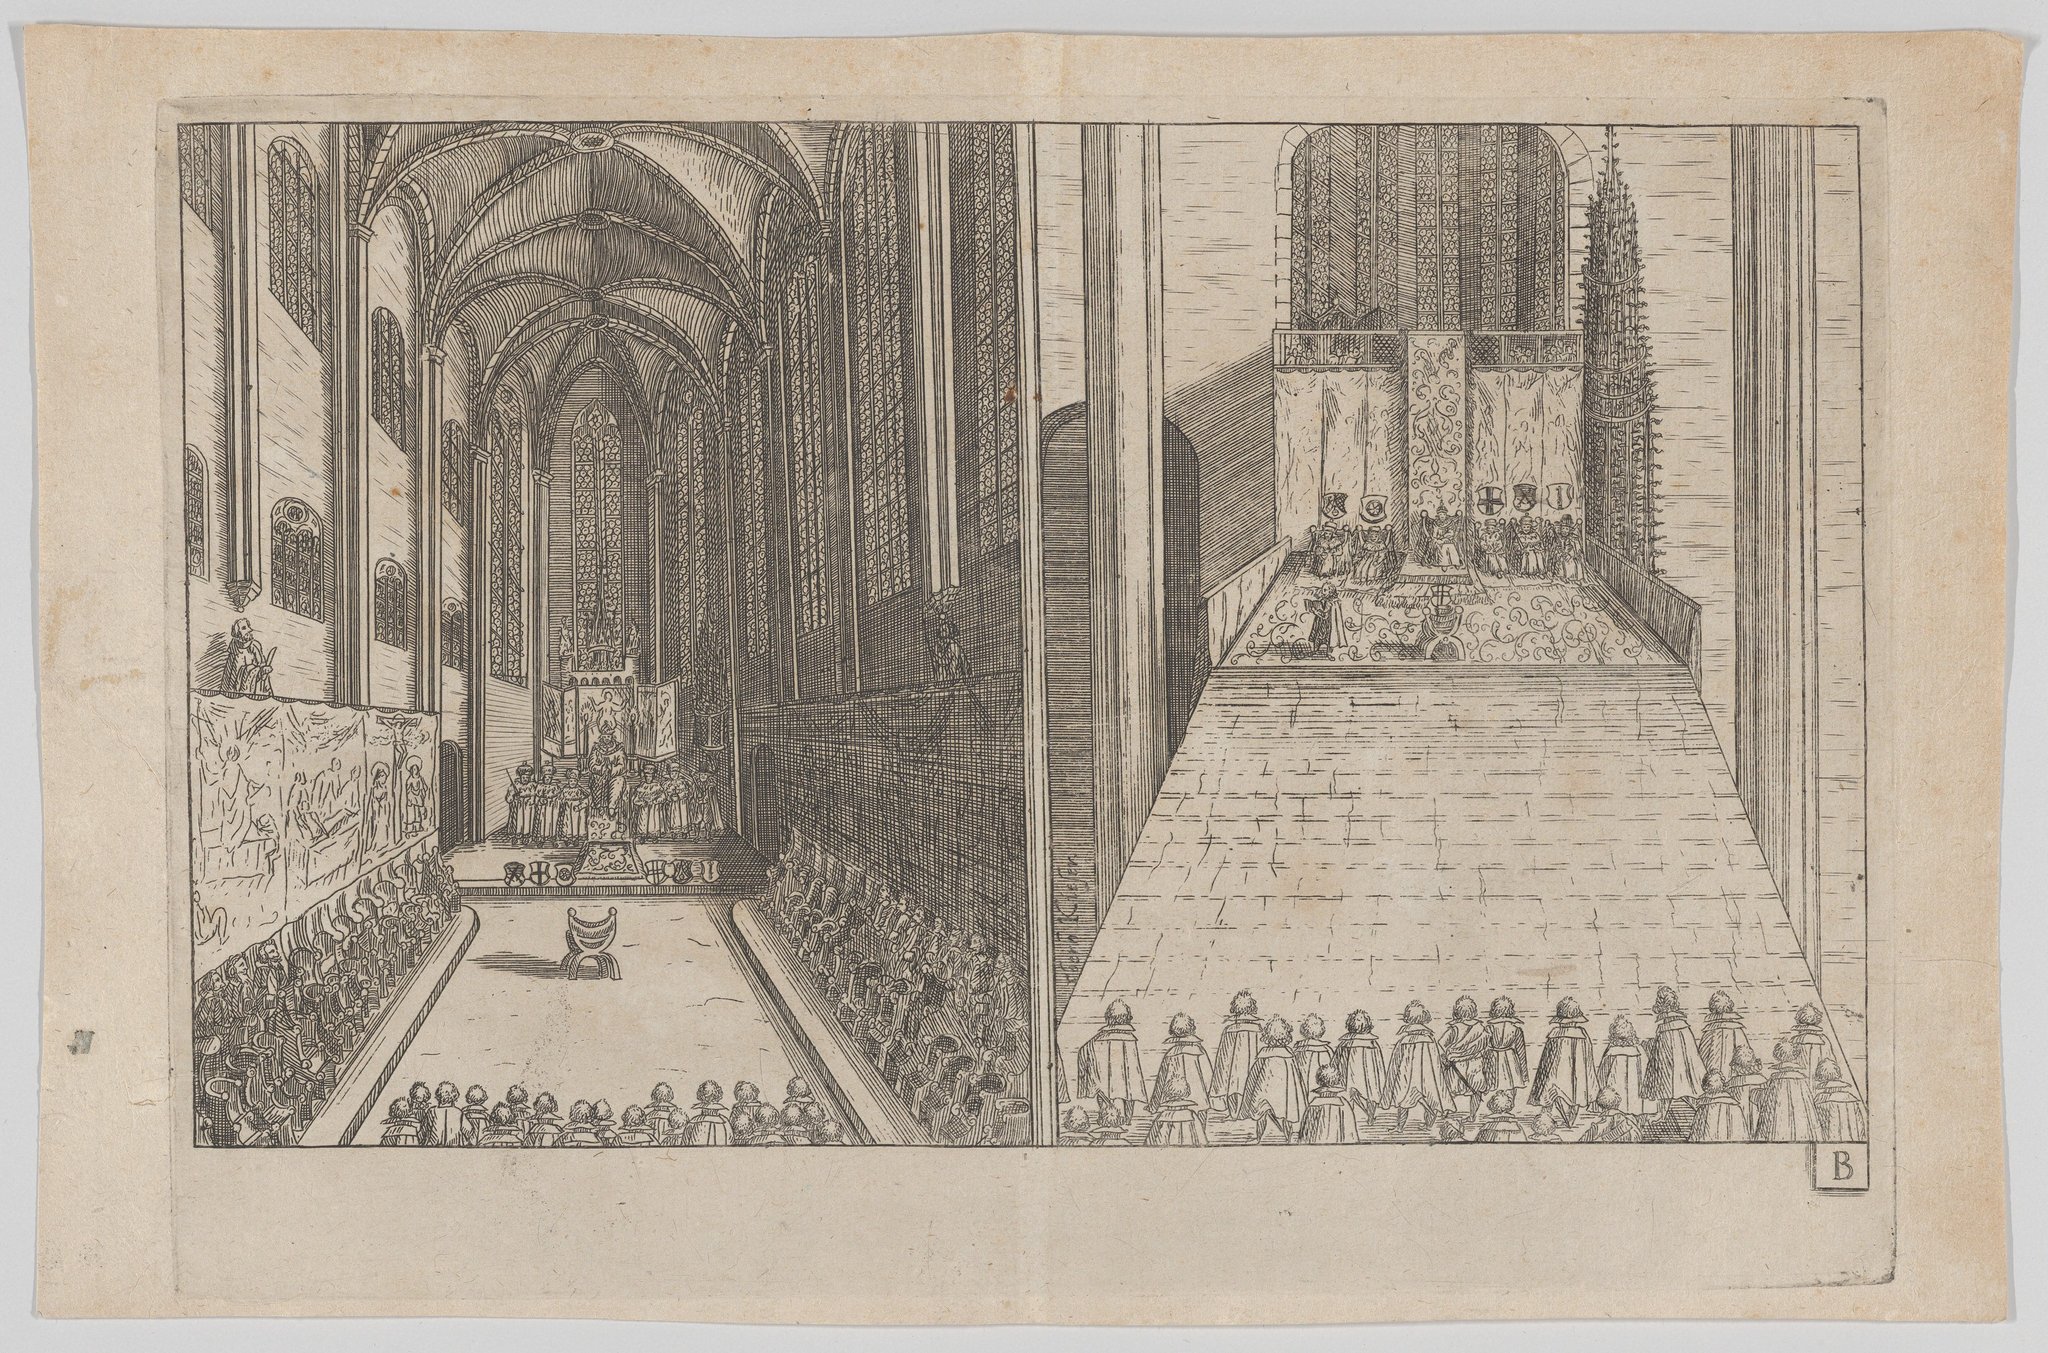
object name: print, fete, ornament architecture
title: Plate B: Election and Coronation of Emperor Maximilian II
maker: anonymous, german, 17th century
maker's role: publisher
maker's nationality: german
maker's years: 1600-1700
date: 1612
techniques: etching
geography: frankfurt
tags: cathedrals,elections,ceremony